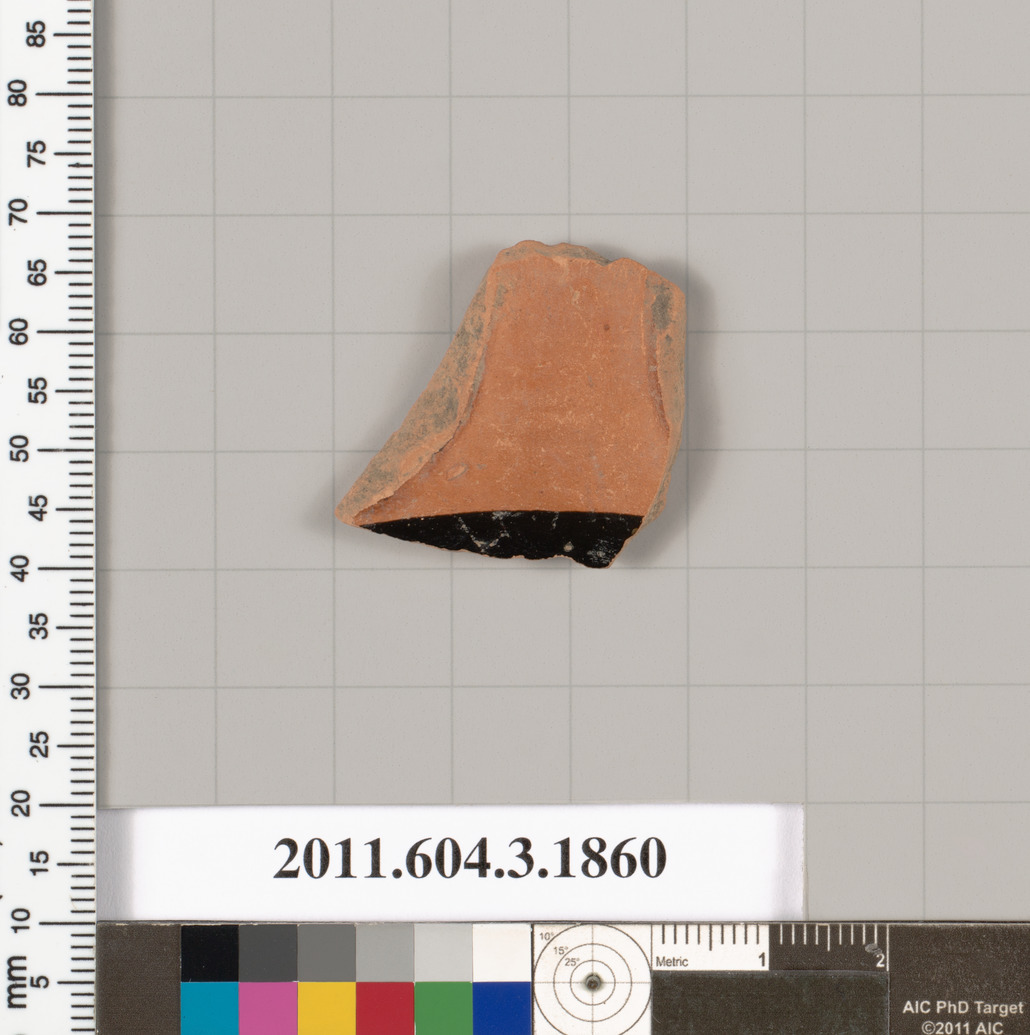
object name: kylix fragment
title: Terracotta fragment of a kylix: Lip cup (drinking cup)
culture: greek, attic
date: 560-525 BCE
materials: terracotta